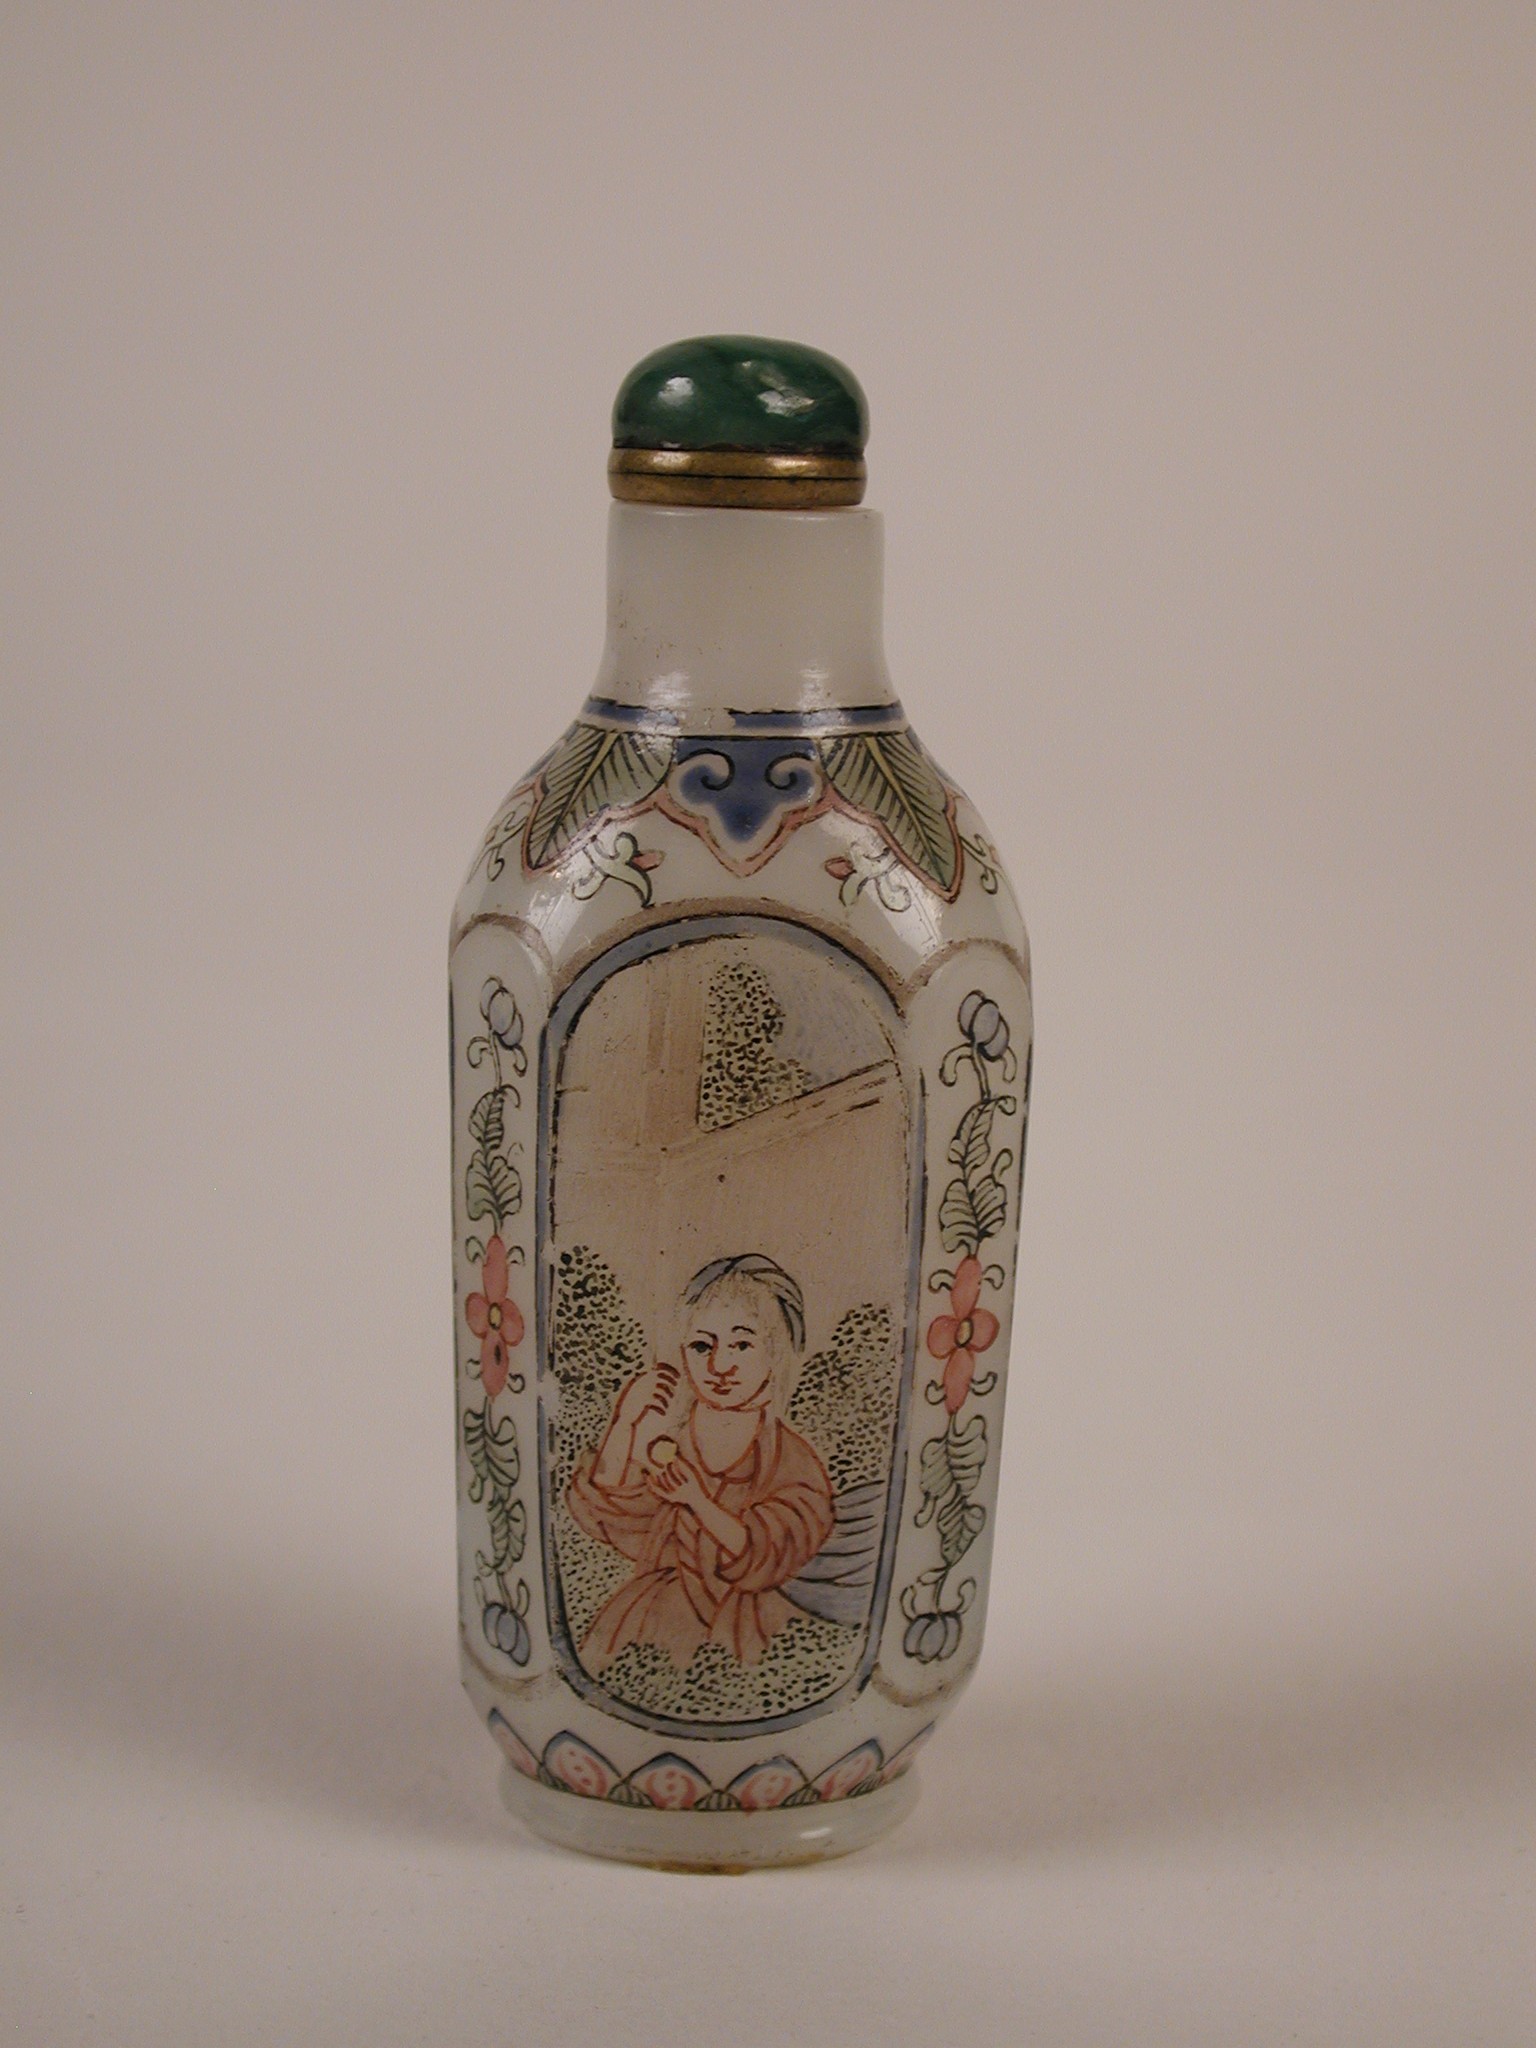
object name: snuff bottle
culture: chinese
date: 1821-1850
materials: glass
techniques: enamel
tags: human figures